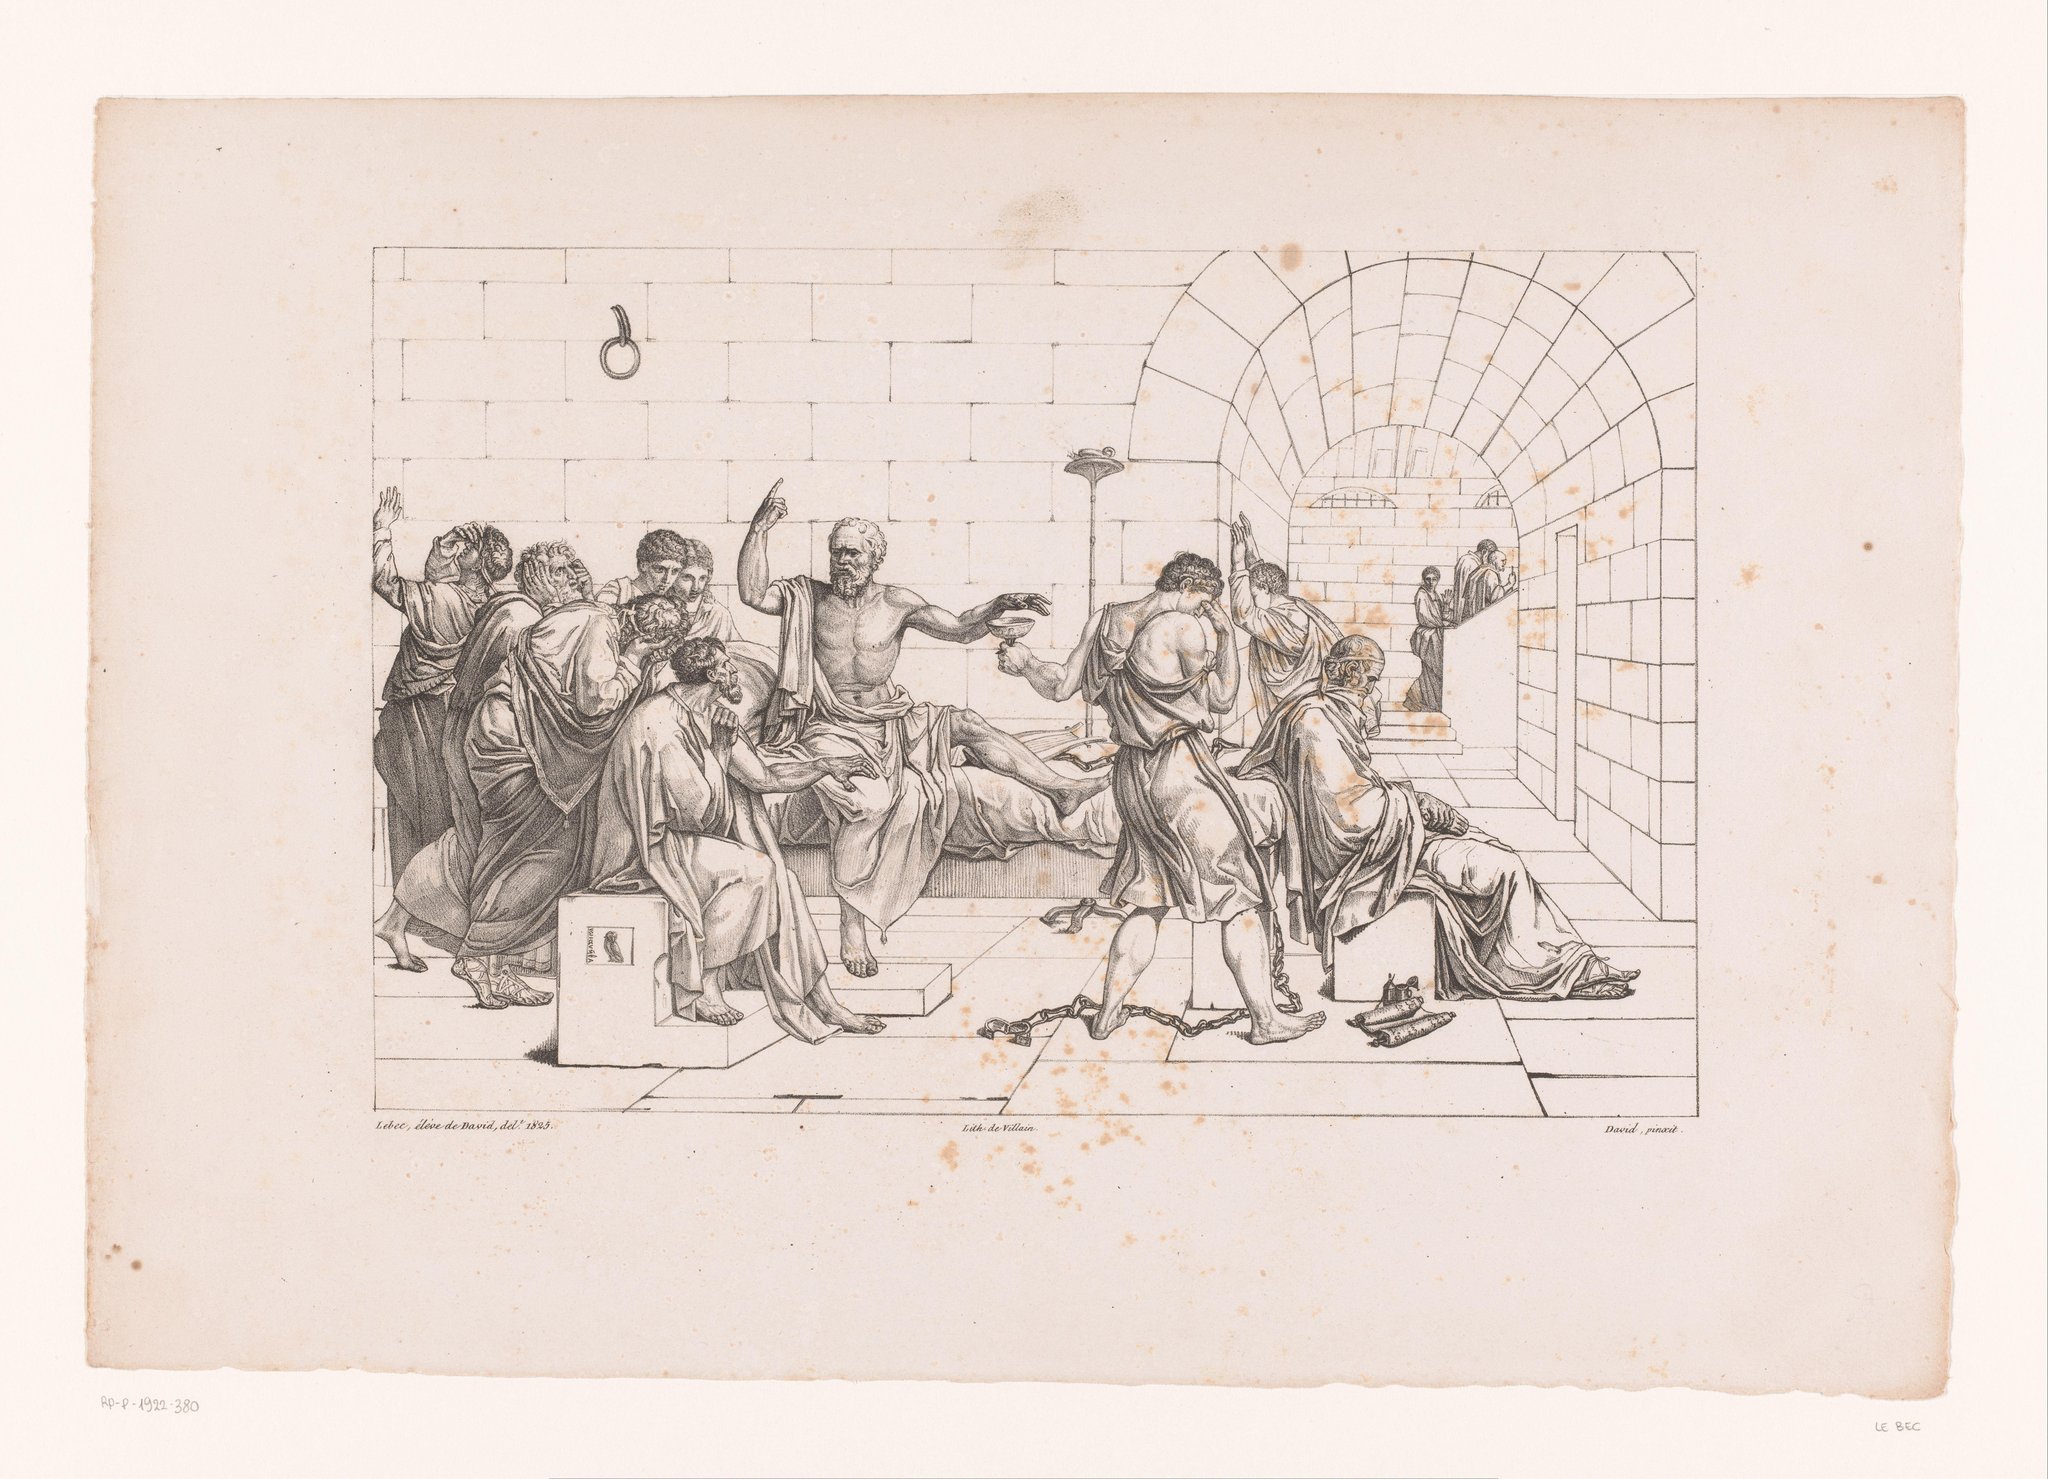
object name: print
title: Dood van Socrates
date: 1825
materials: paper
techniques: lithograph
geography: paris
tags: death of socrates: in prison, surrounded by his grieving disciples, he calmly drinks the cup of poison after having made a libation to the gods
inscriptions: collector's mark: Lugt 2233